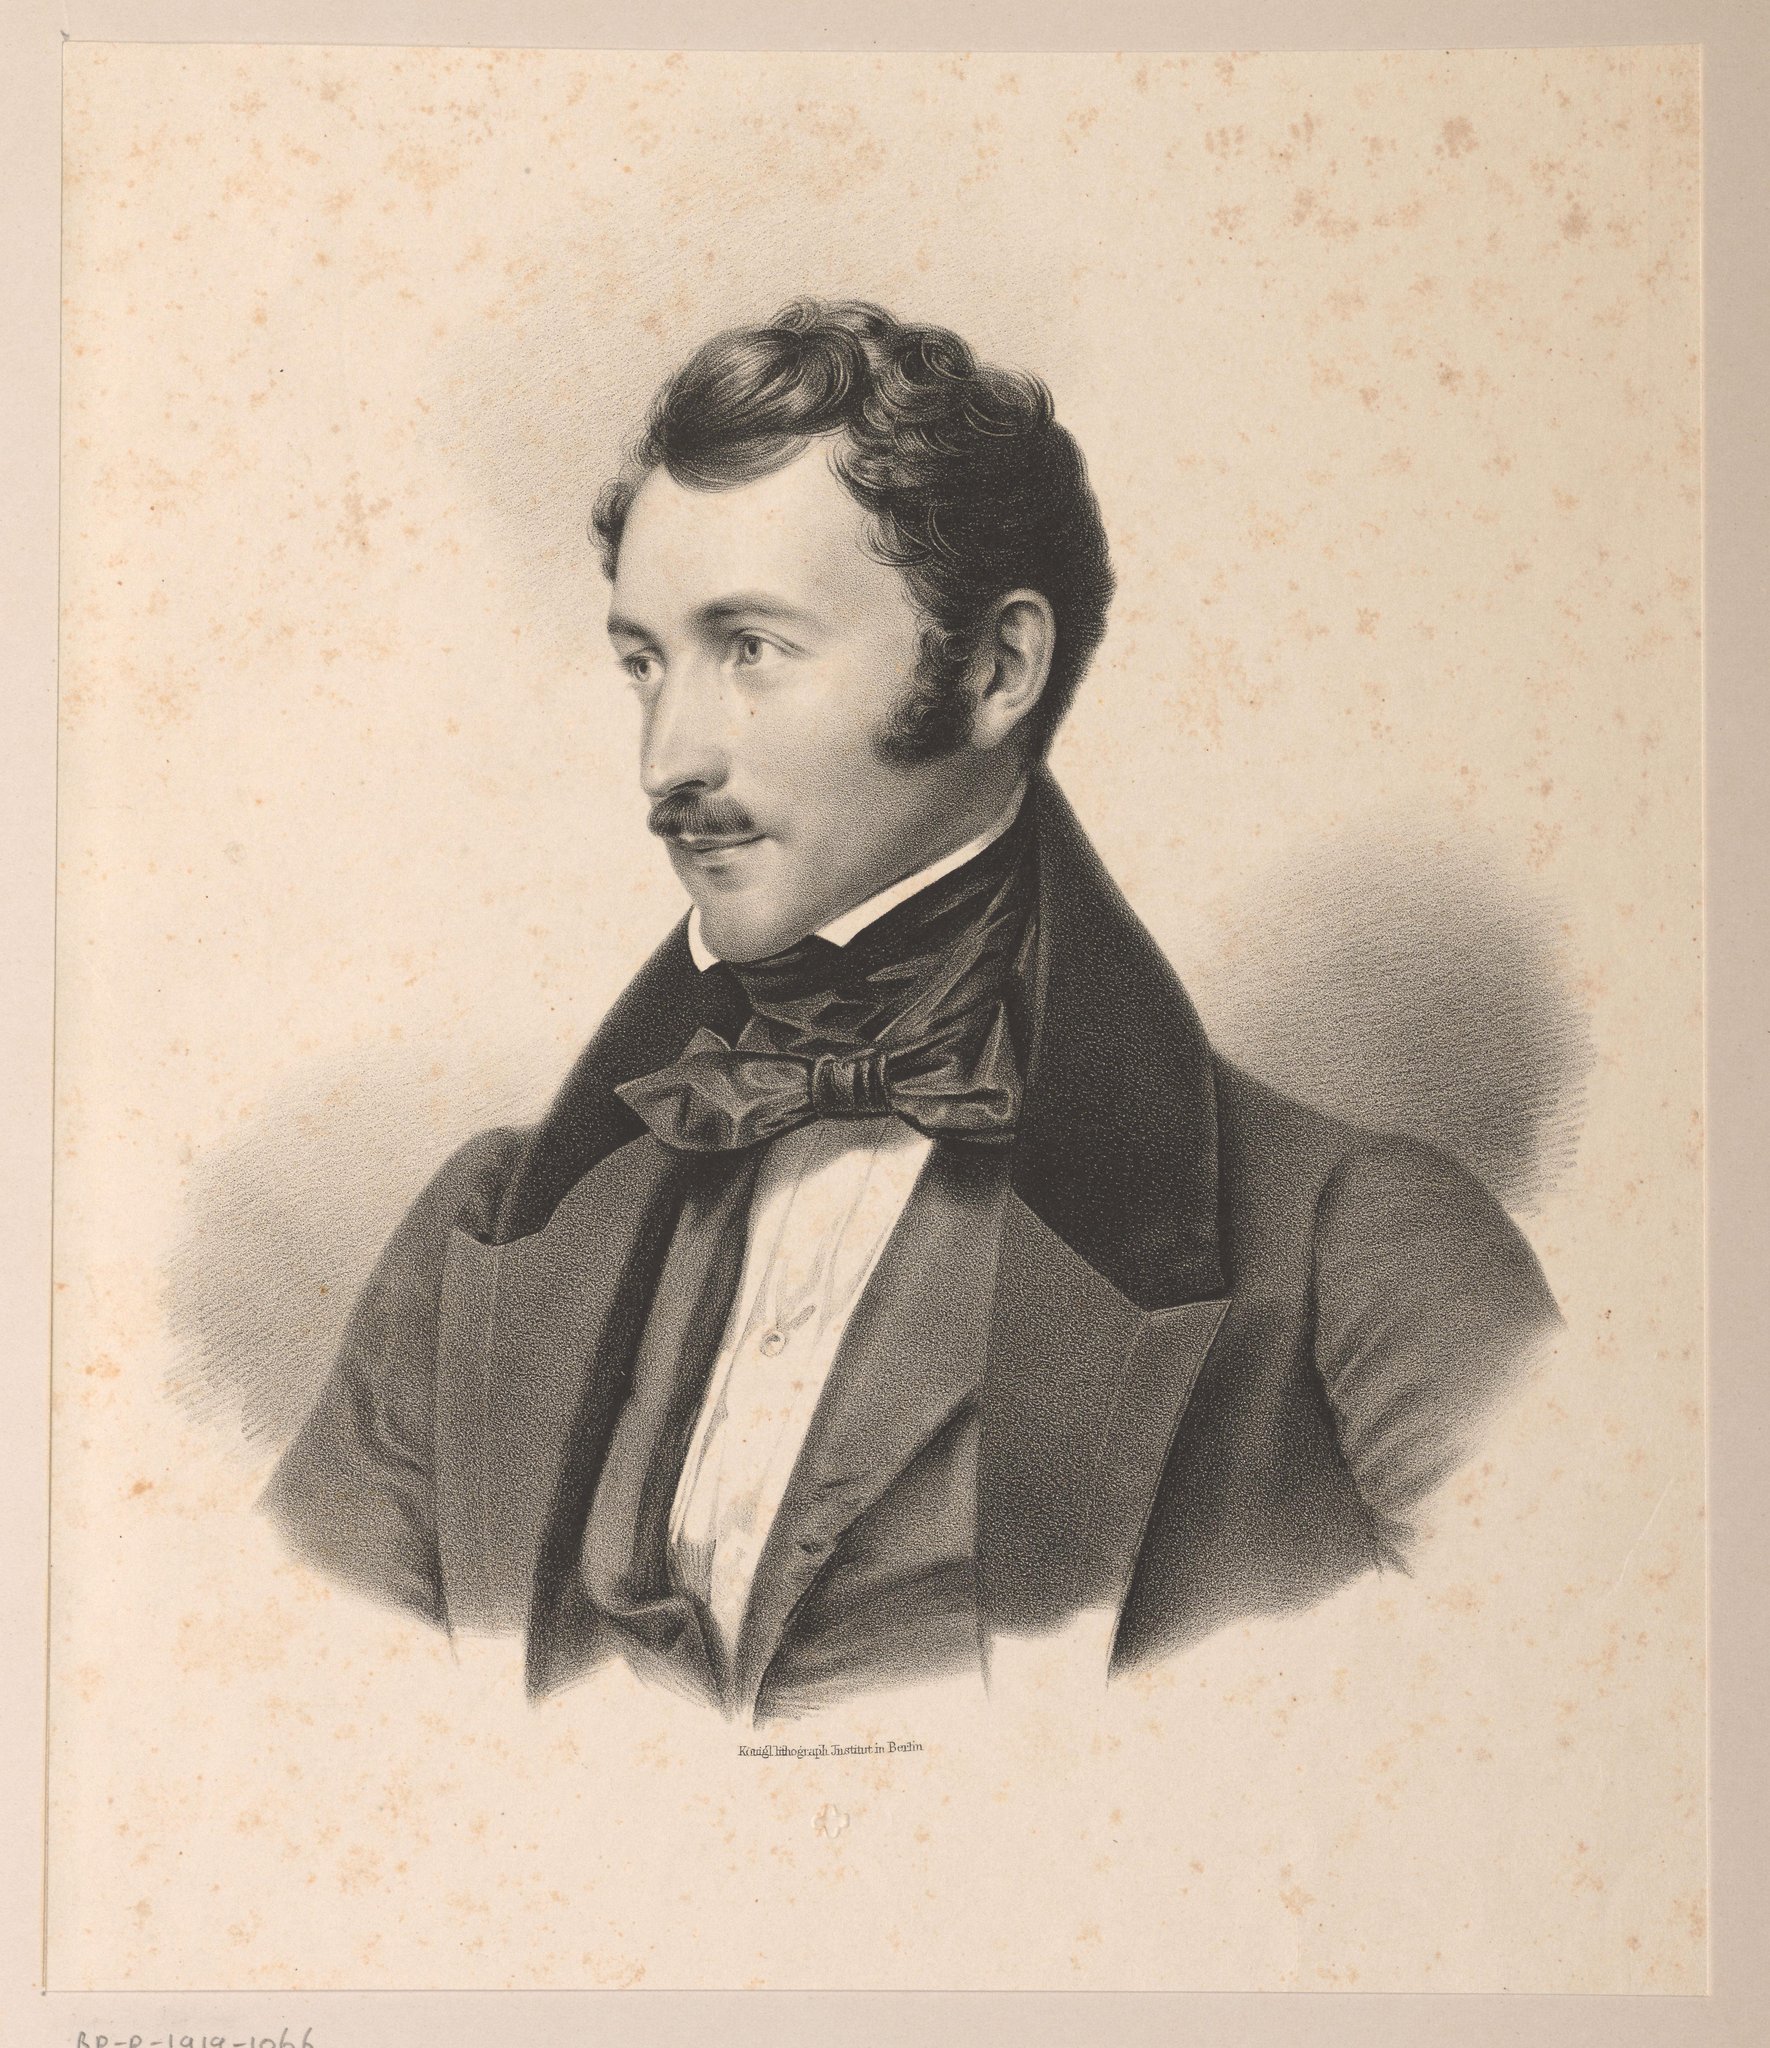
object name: print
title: Portret van Rochus Otto Manderup Heinrich zu Lynar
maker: Anonymous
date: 1830-1861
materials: paper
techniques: lithograph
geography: berlin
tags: politician, historical persons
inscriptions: check stamp, collector's mark: Lugt 2228